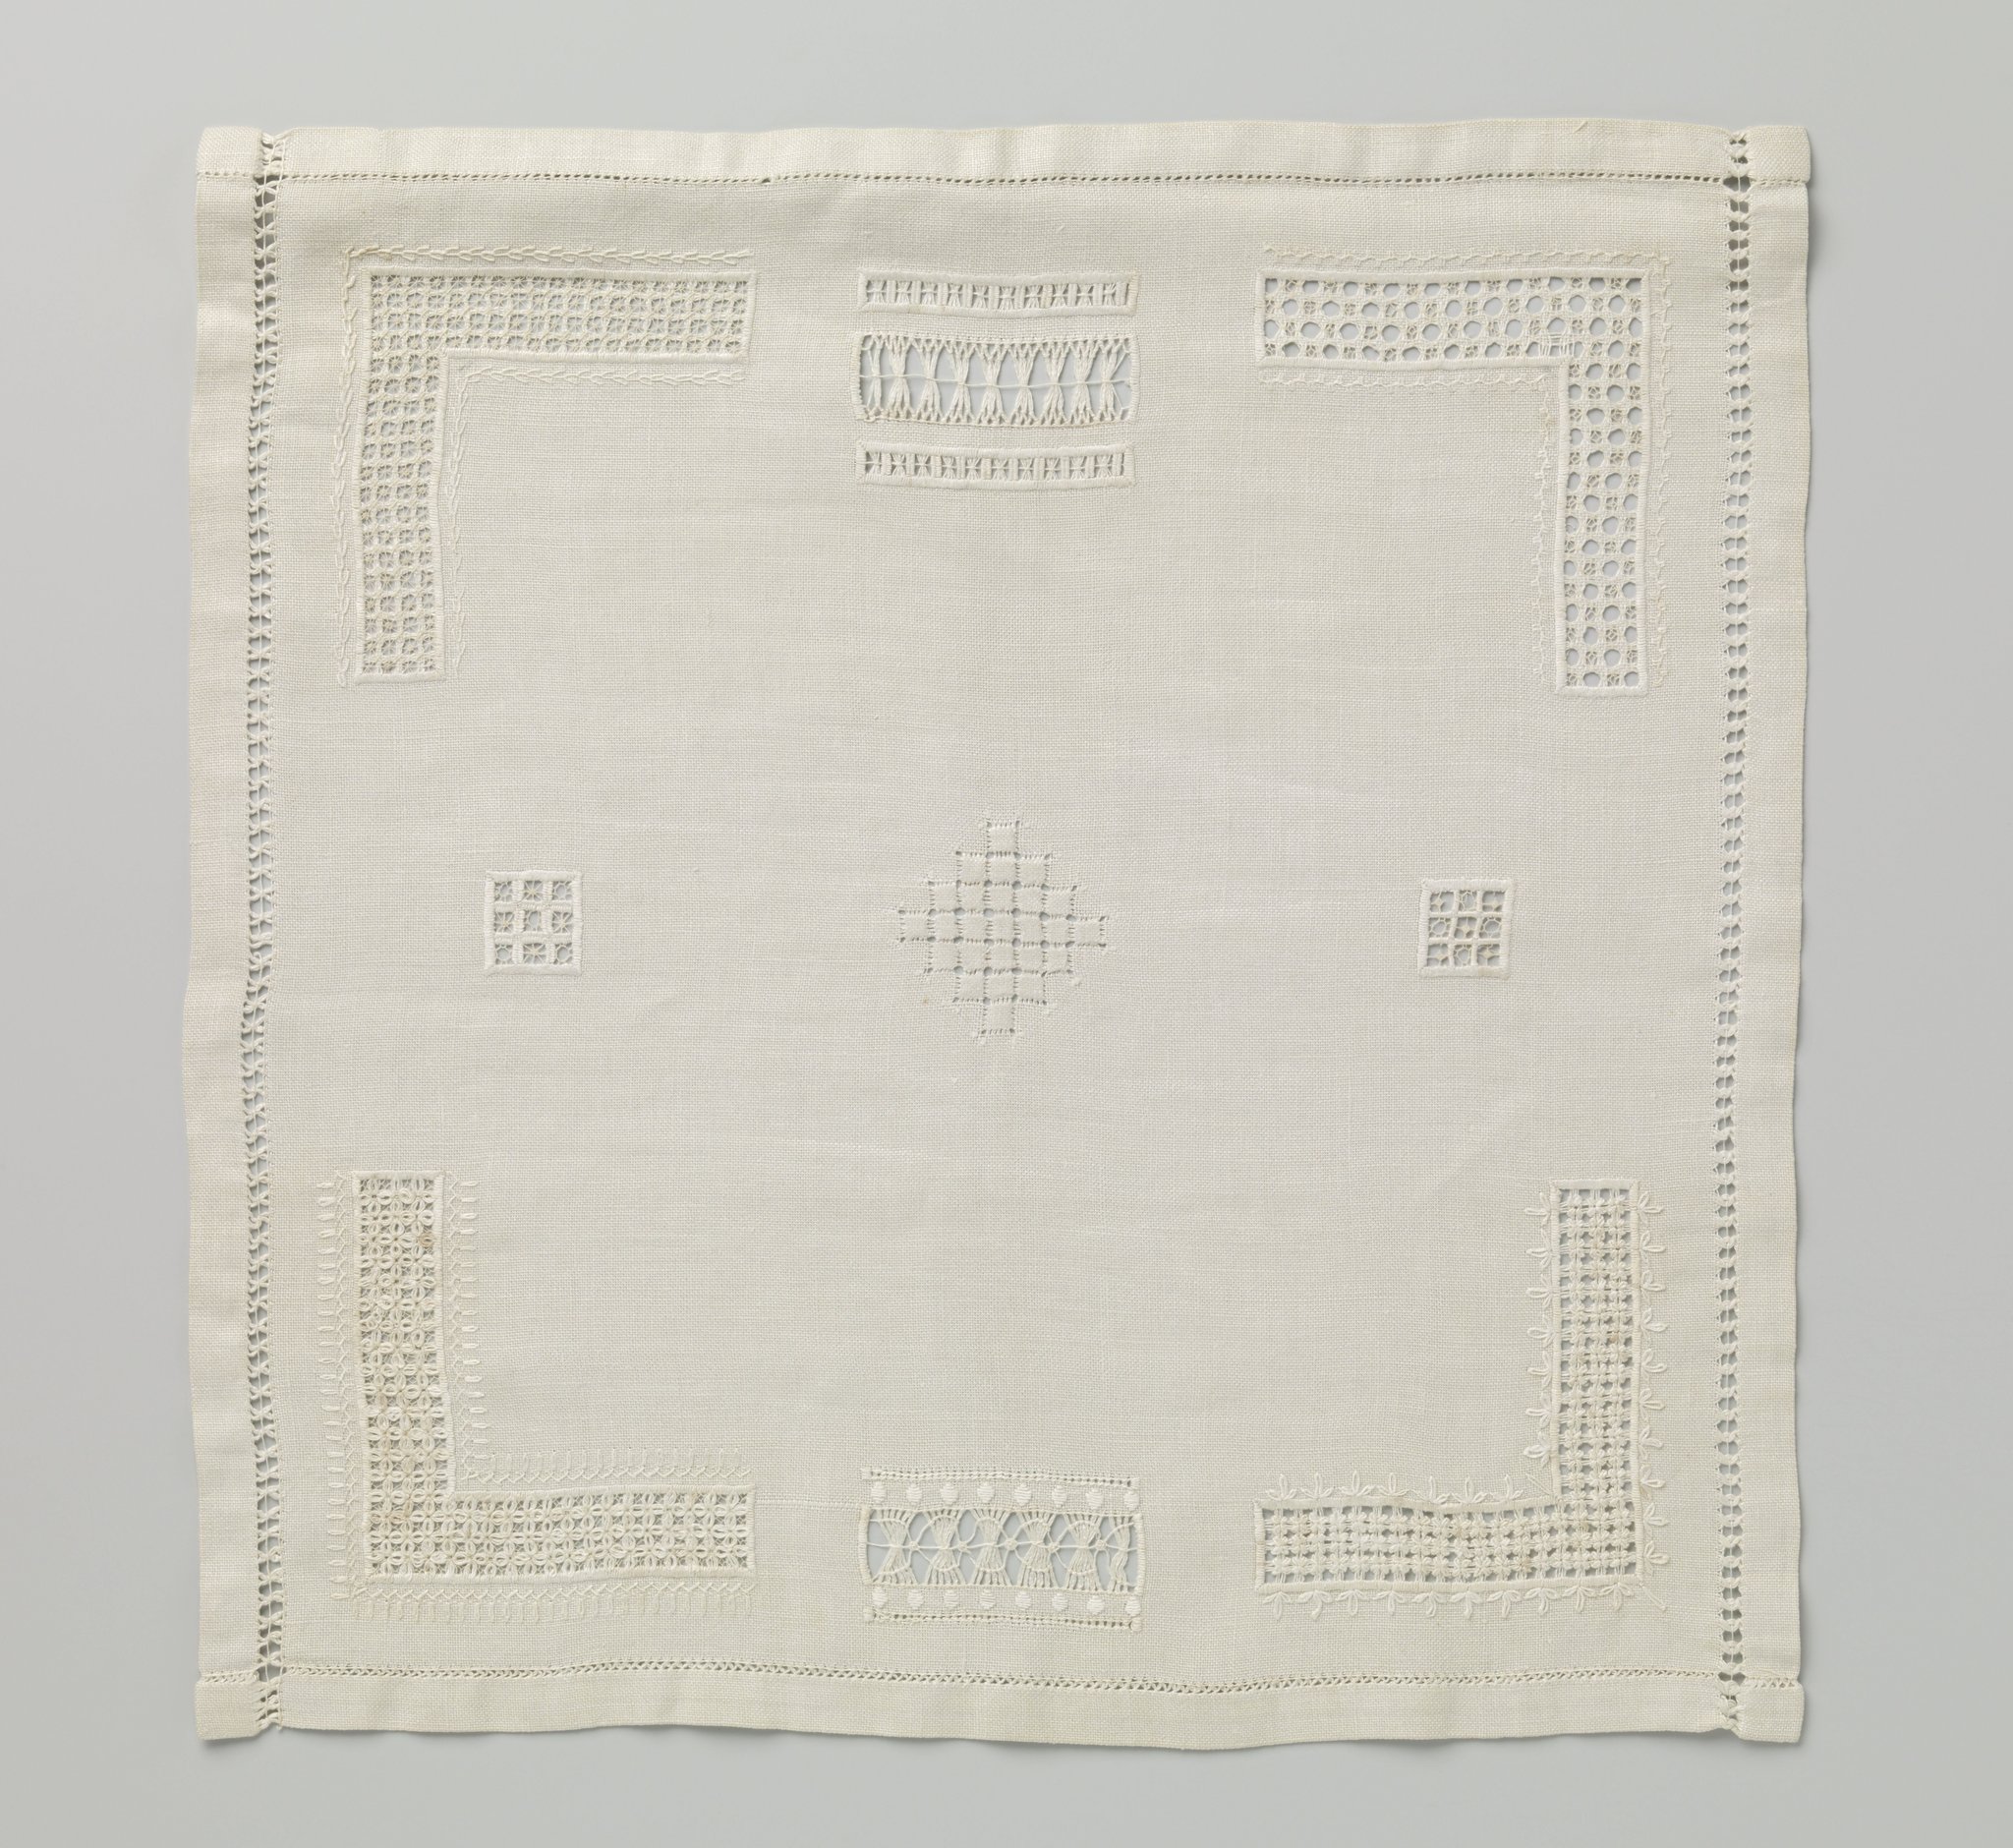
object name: naaiwerk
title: Open naailap van wit linnen op linnen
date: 1880-1905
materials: linen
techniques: embroidered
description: Open naailap van linnen op linnen. Het borduurwerk heeft negen proeven, een open zoom en Zweedse naden.